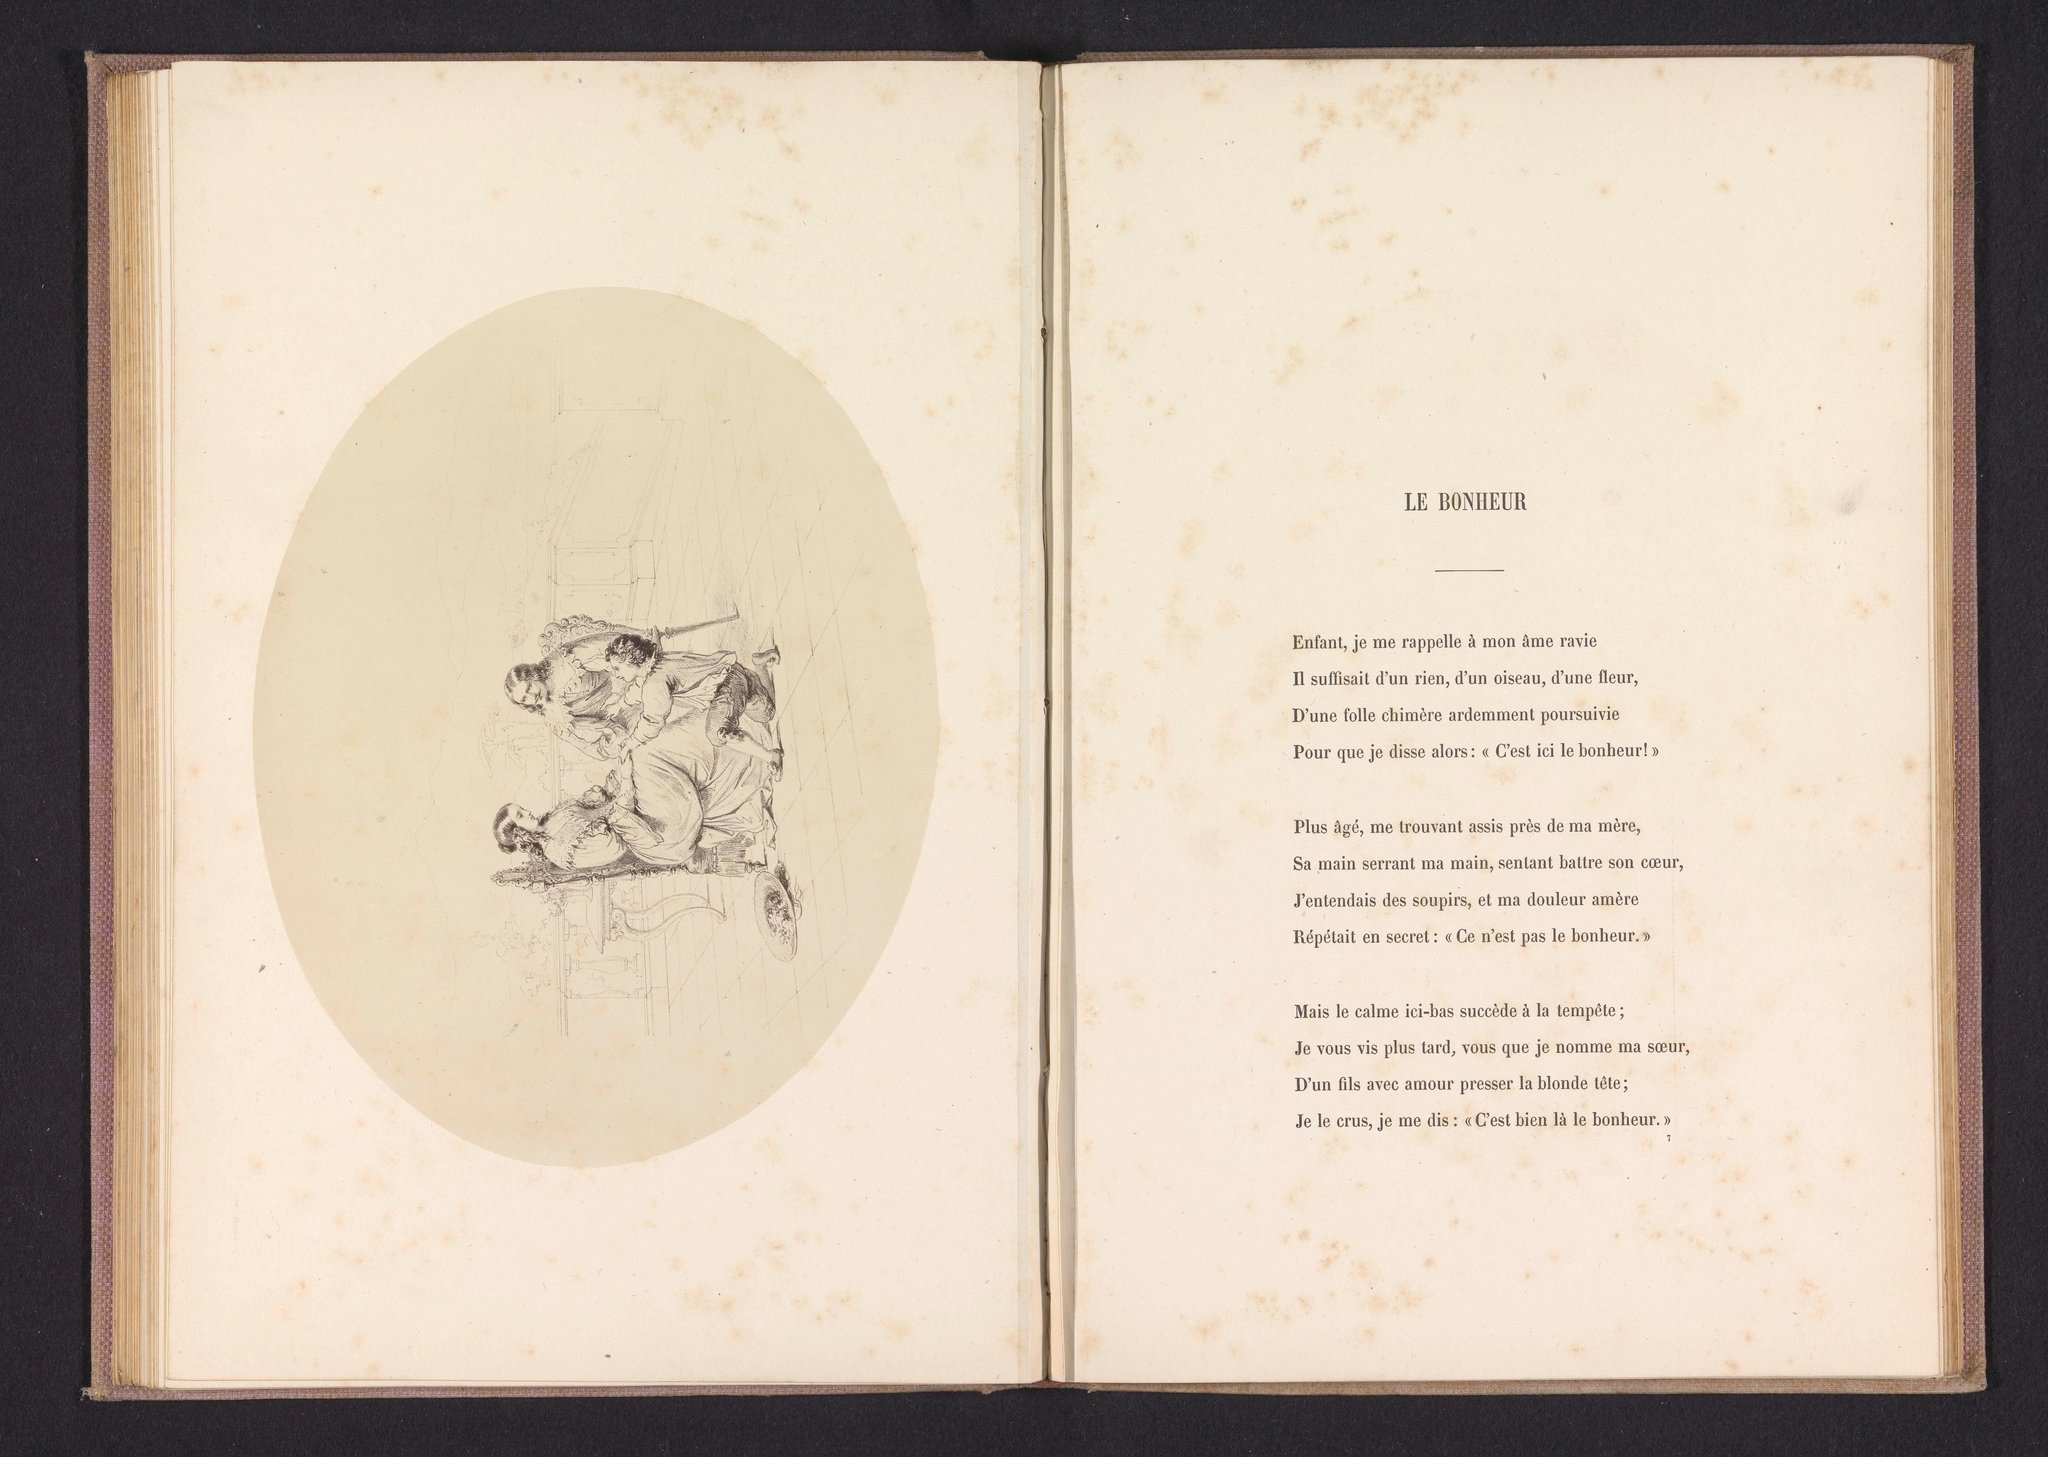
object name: reproduction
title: Fotoreproductie van een tekening, voorstellende een jongen knielt voor zijn ouders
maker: Anonymous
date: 1857-1867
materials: photographic support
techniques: albumen print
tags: parents with their children, kneeling figure